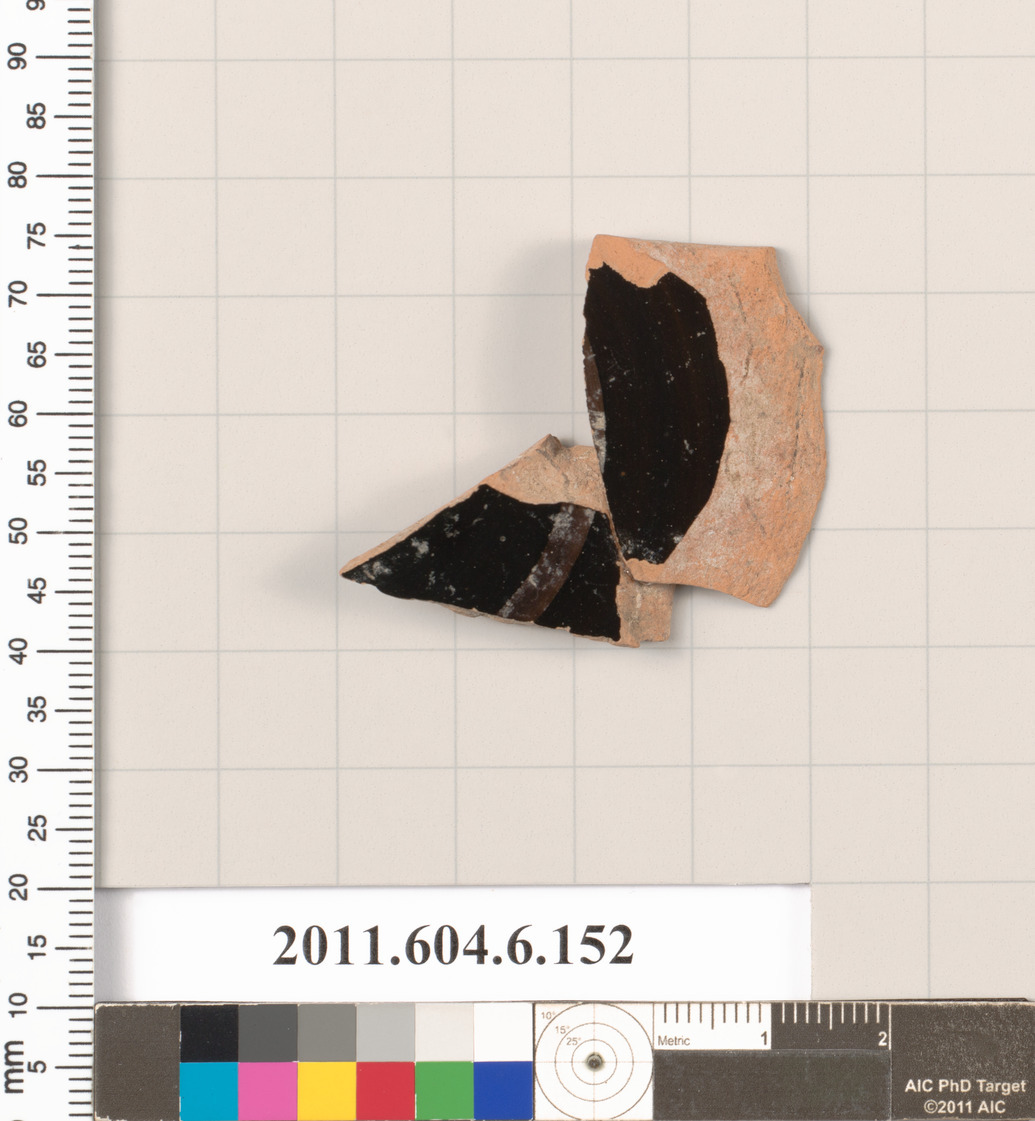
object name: undetermined closed shape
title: Terracotta fragment of a closed shape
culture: greek, attic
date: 600-401 BCE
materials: terracotta